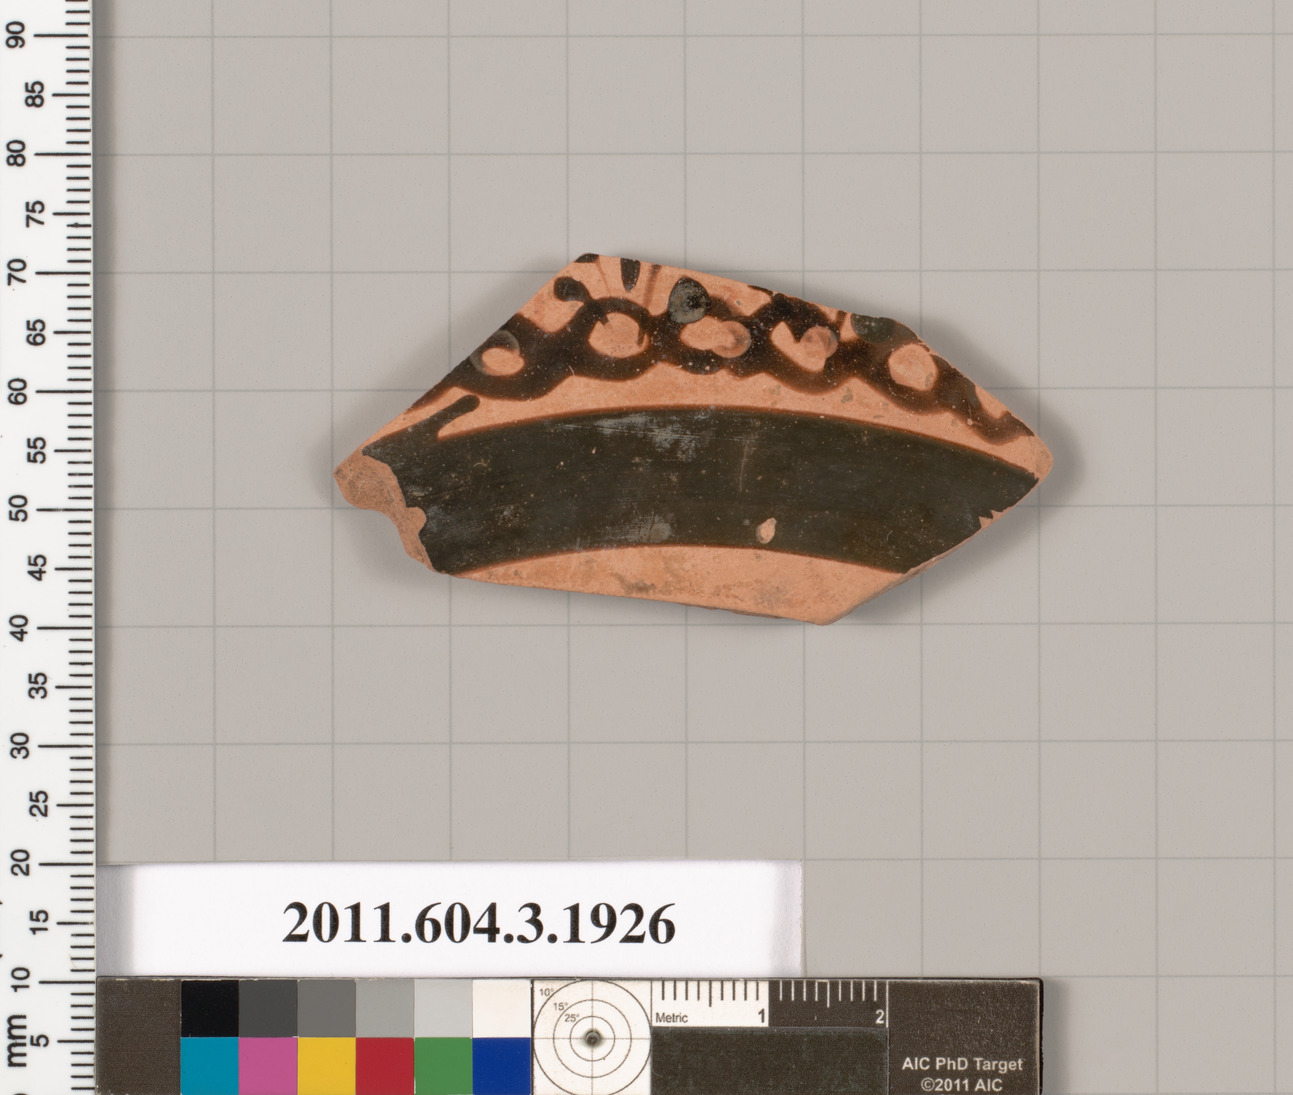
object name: kylix or skyphos fragment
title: Terracotta fragment of a kylix (drinking cup) or a skyphos (deep drinking cup)?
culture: greek, attic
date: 534-468 BCE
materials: terracotta